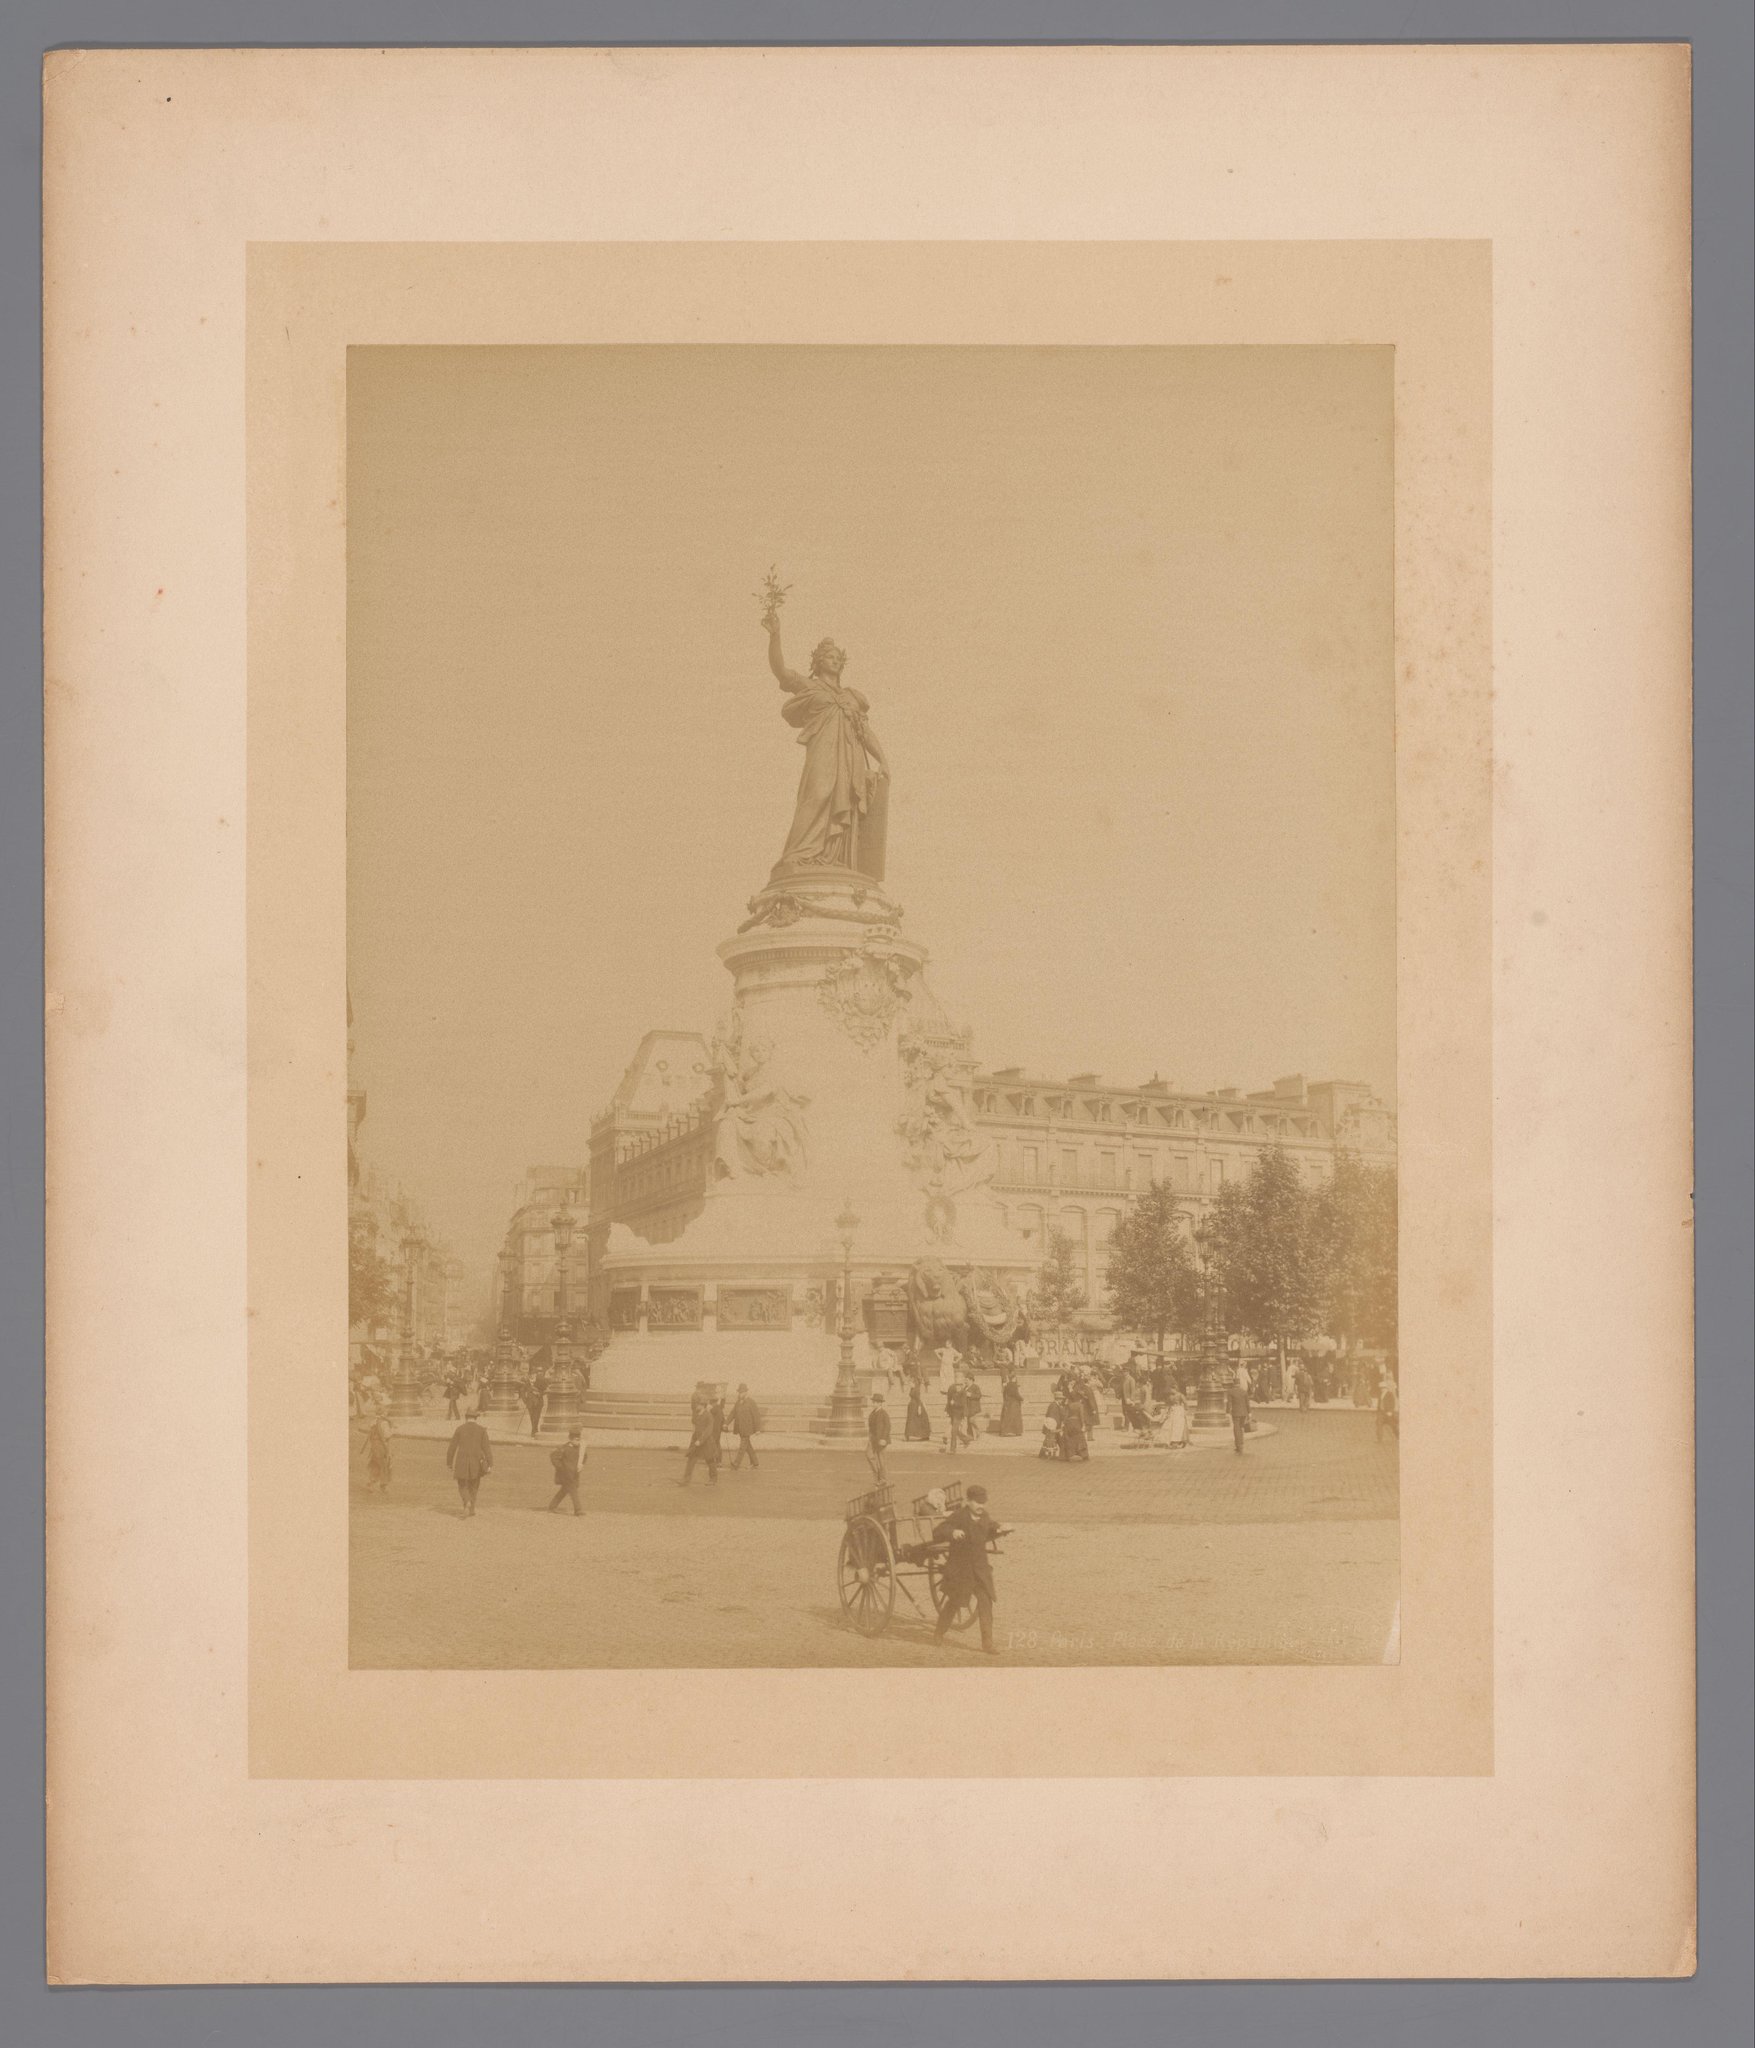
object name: photograph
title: Place de la République, Parijs, Frankrijk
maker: j. kühn (uitgever)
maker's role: publisher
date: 1885-1910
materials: paper, photographic support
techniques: albumen print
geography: paris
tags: place de la république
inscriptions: check stamp: ‘Photographie Company//J. KUHN//Paris//220 170 174 Rue de Rivoli’, inscription: ‘128 Paris. Place de la Republique’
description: Place de la République, Parijs, Frankrijk.